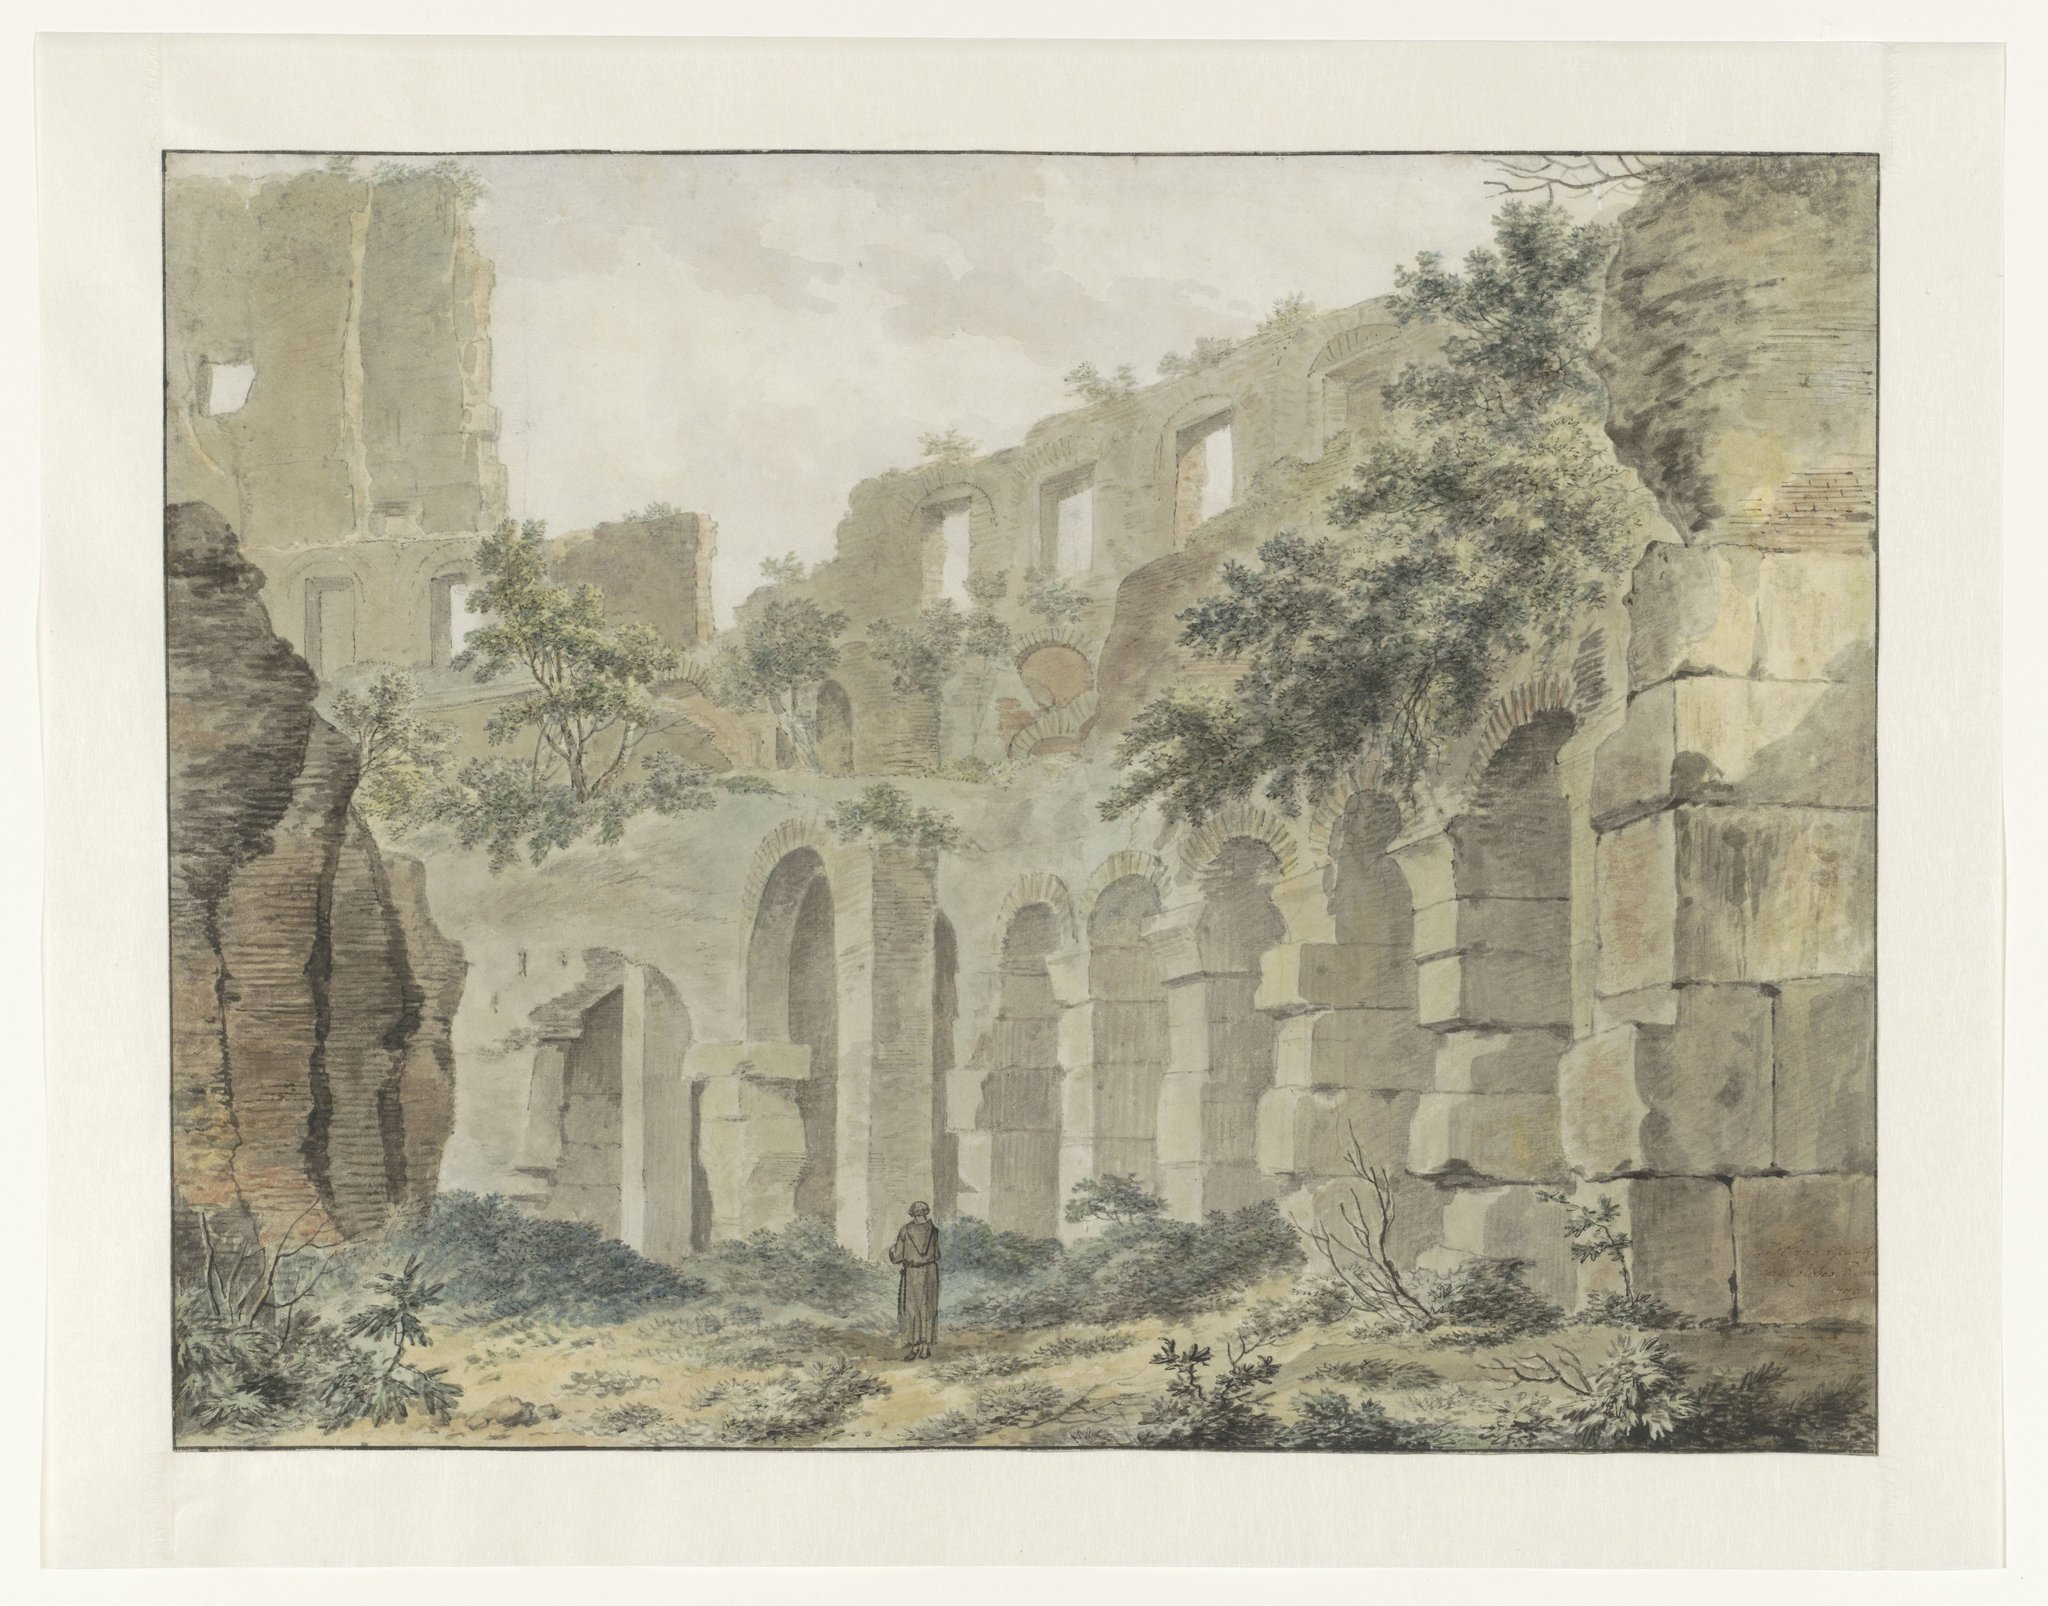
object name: drawing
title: Gezicht in het Colosseum met op de voorgrond een monnik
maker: jean grandjean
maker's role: draughtsman, print maker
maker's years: 1752-1781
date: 1779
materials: chalk, paper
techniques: brush, pen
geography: rome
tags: ruin of a building ~ architecture, landscape with ruins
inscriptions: signature: ‘Jn GrandJean f[ec; afgesneden] / int Coliseo Roma / 1779’